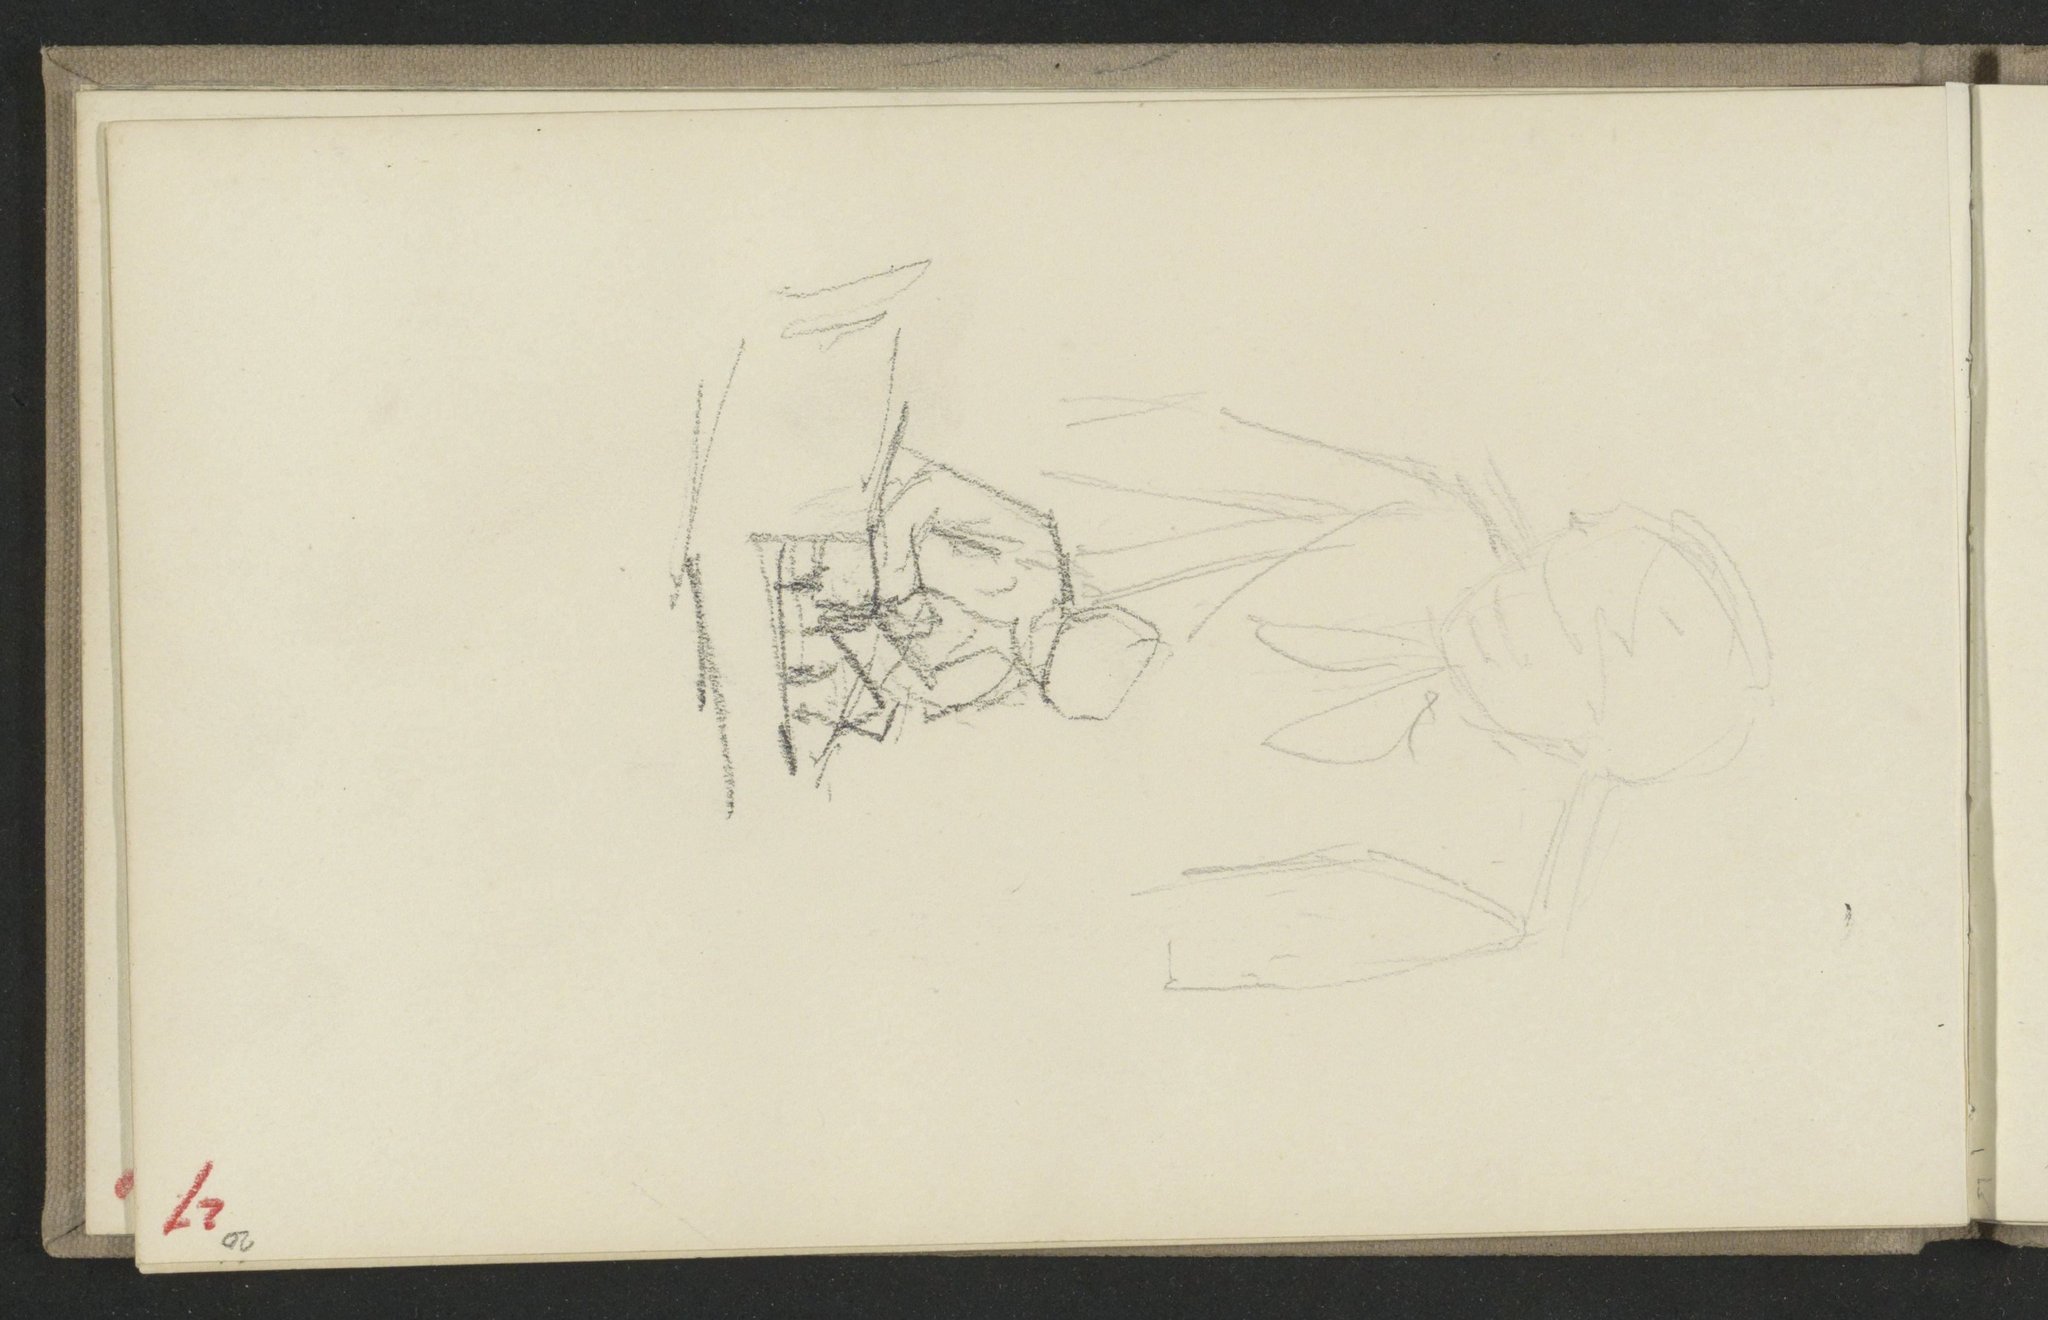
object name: sketchbook leaf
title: Bovenlichaam van een figuur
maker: jozef israëls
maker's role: draughtsman, painter, print maker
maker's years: 1824-1911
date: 1834-1911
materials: paper, pencil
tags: anatomy (non-medical)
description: Tevens een studie van een figuur achter een werkbank of bureau. Blad 6 verso uit een schetsboek met 26 bladen.